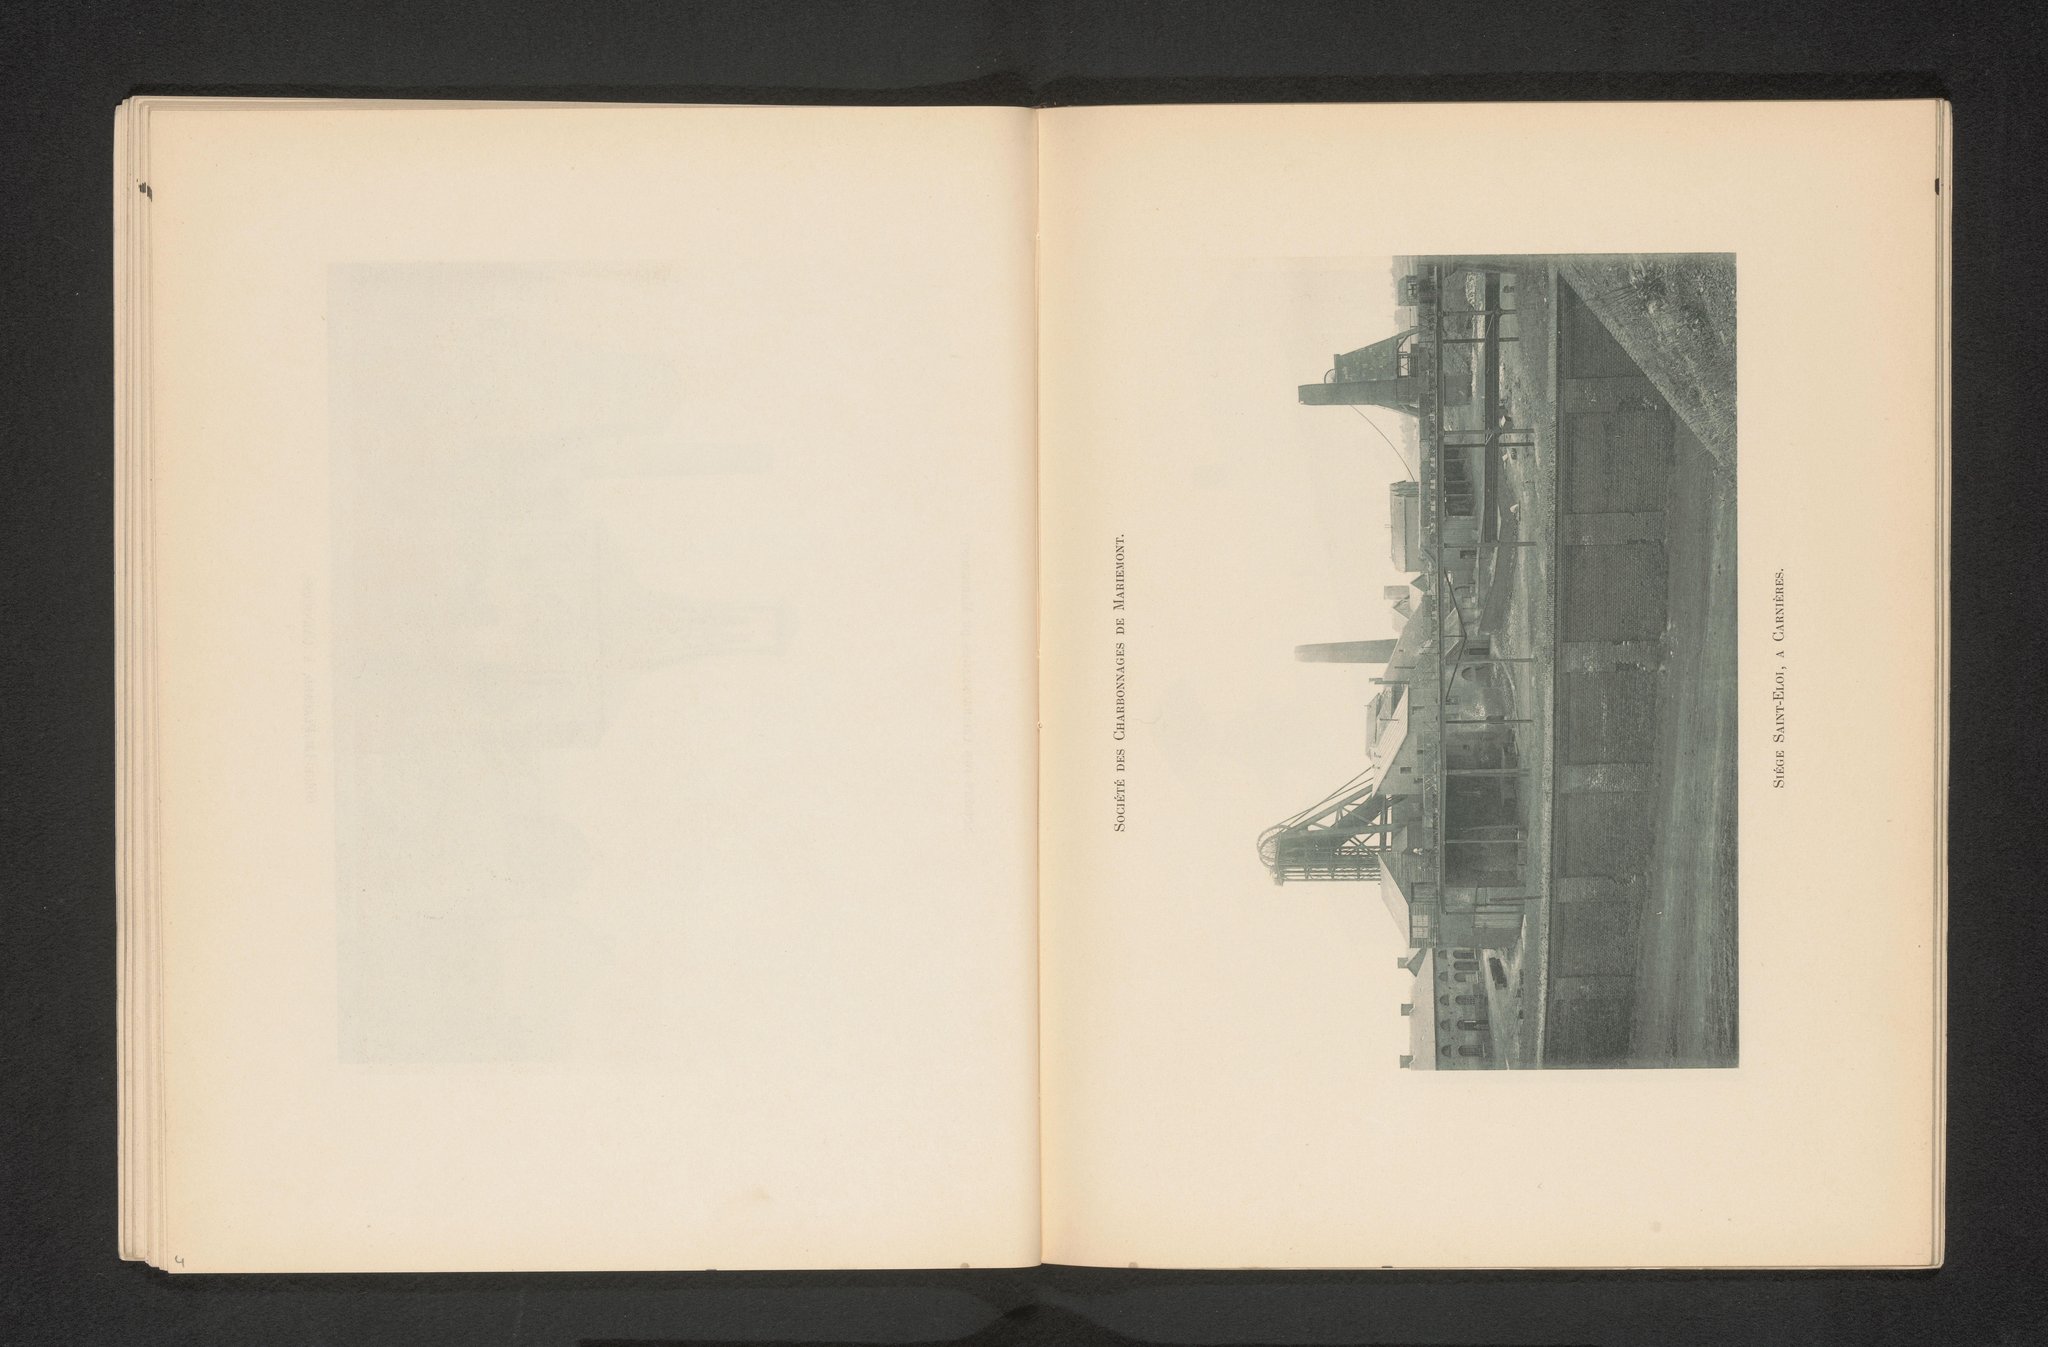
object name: photomechanical print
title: Siége Saint-Eloi, a Carnières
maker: Anonymous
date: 1895-1900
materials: paper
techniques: photograph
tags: mine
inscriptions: inscription: ‘Société des Charbonnages de Mariemont’